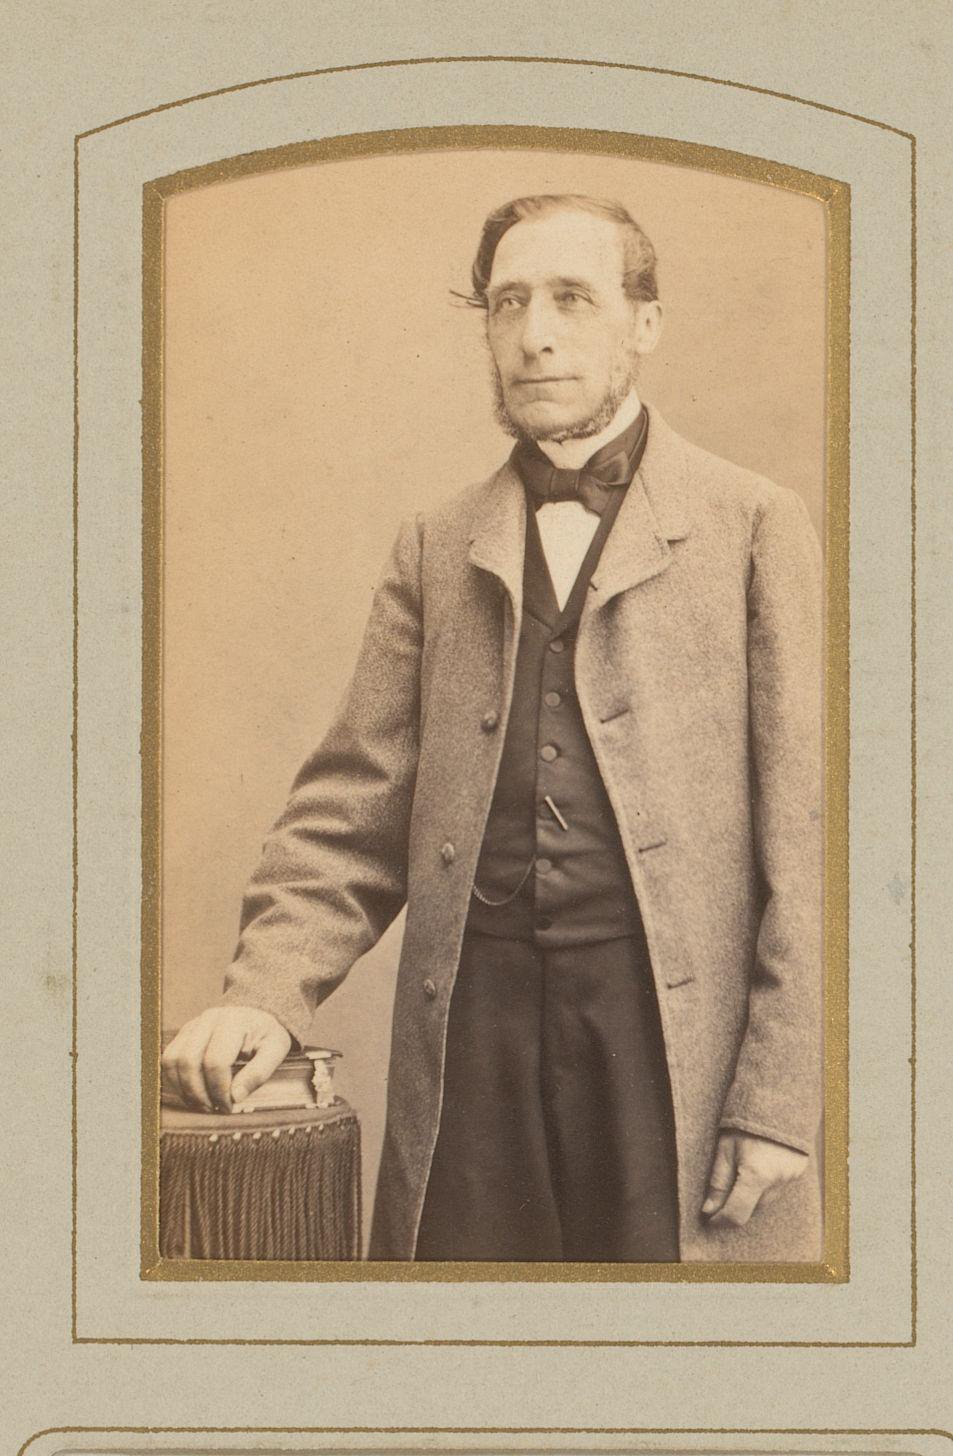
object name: carte de visite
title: Portret van een staande man met zijn hand rustend op een boek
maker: louis désiré dupont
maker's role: fotograaf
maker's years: 1825-1878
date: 1864-1901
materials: cardboard, photographic support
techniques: albumen print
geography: brussels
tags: standing figure, historical persons, book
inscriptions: inscription: ‘PHOTOGRAPHIE INSTANTANÉE/ Mr & Me DUPONT/ PHOTOGRAPHES/ 67, Rue Neuve 67./ BRUXELLES/ Atelier de pose au premier./ Les Clichés étant toujours indéfiniment/ on peut toujours se procurer de nouvelles/ épreuves de Cartes & Portraits sans reposer’